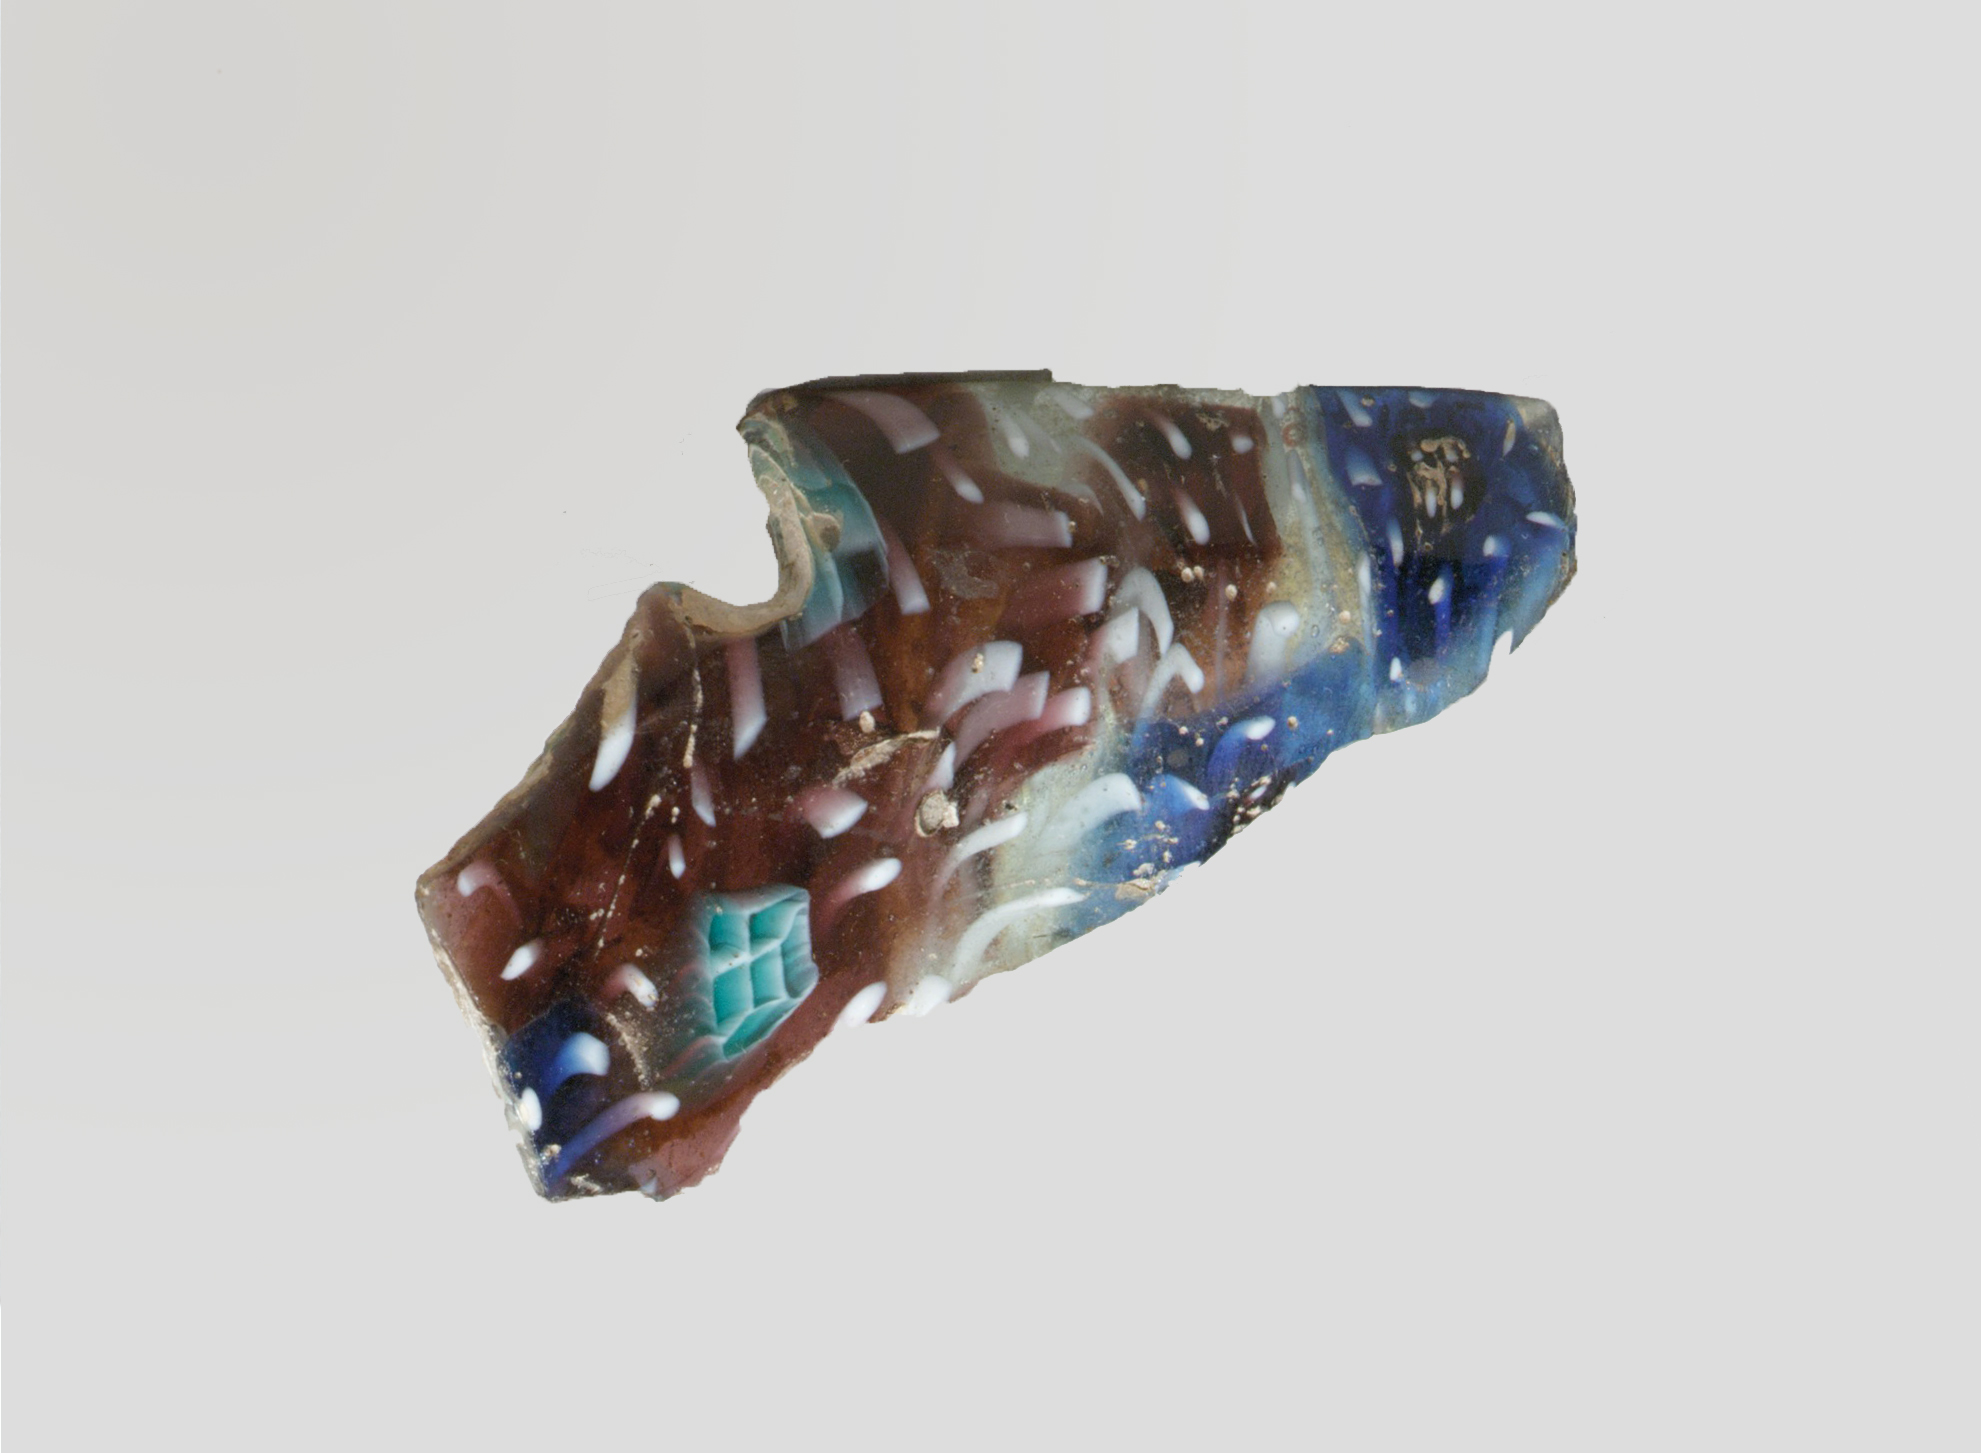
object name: fragment, mosaic bowl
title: Glass mosaic ribbed bowl fragment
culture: roman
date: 34 BCE-33 CE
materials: glass